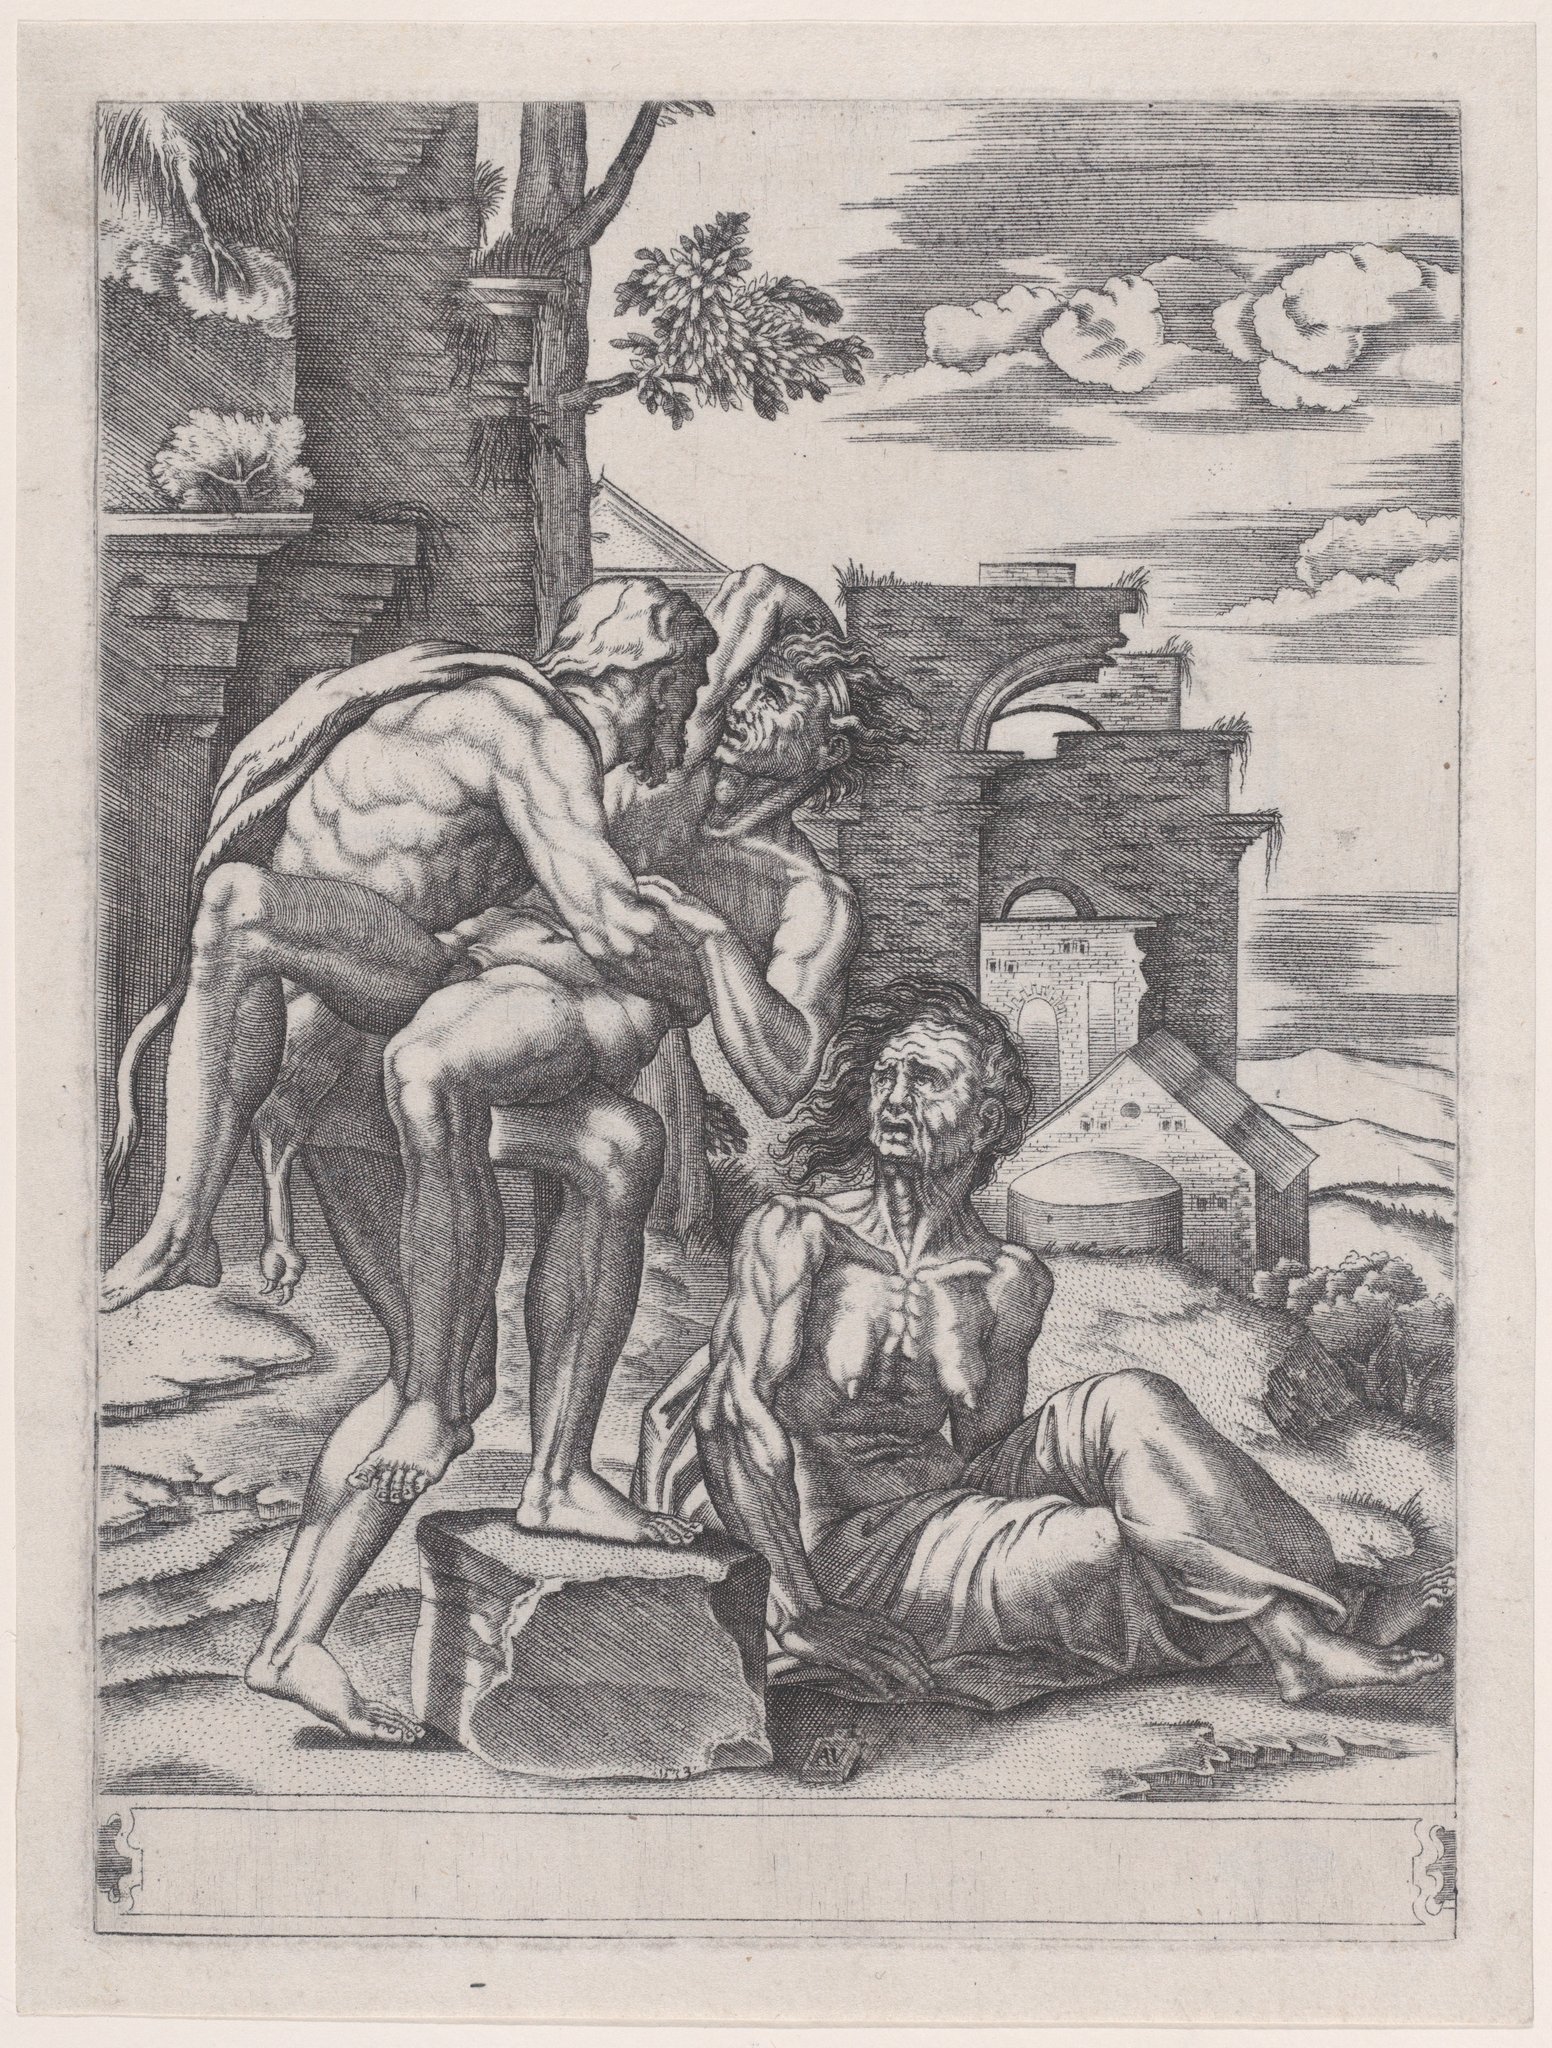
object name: print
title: Hercules and Antaeus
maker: agostino veneziano (agostino dei musi)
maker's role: artist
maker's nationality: italian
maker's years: 1490-1536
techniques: engraving